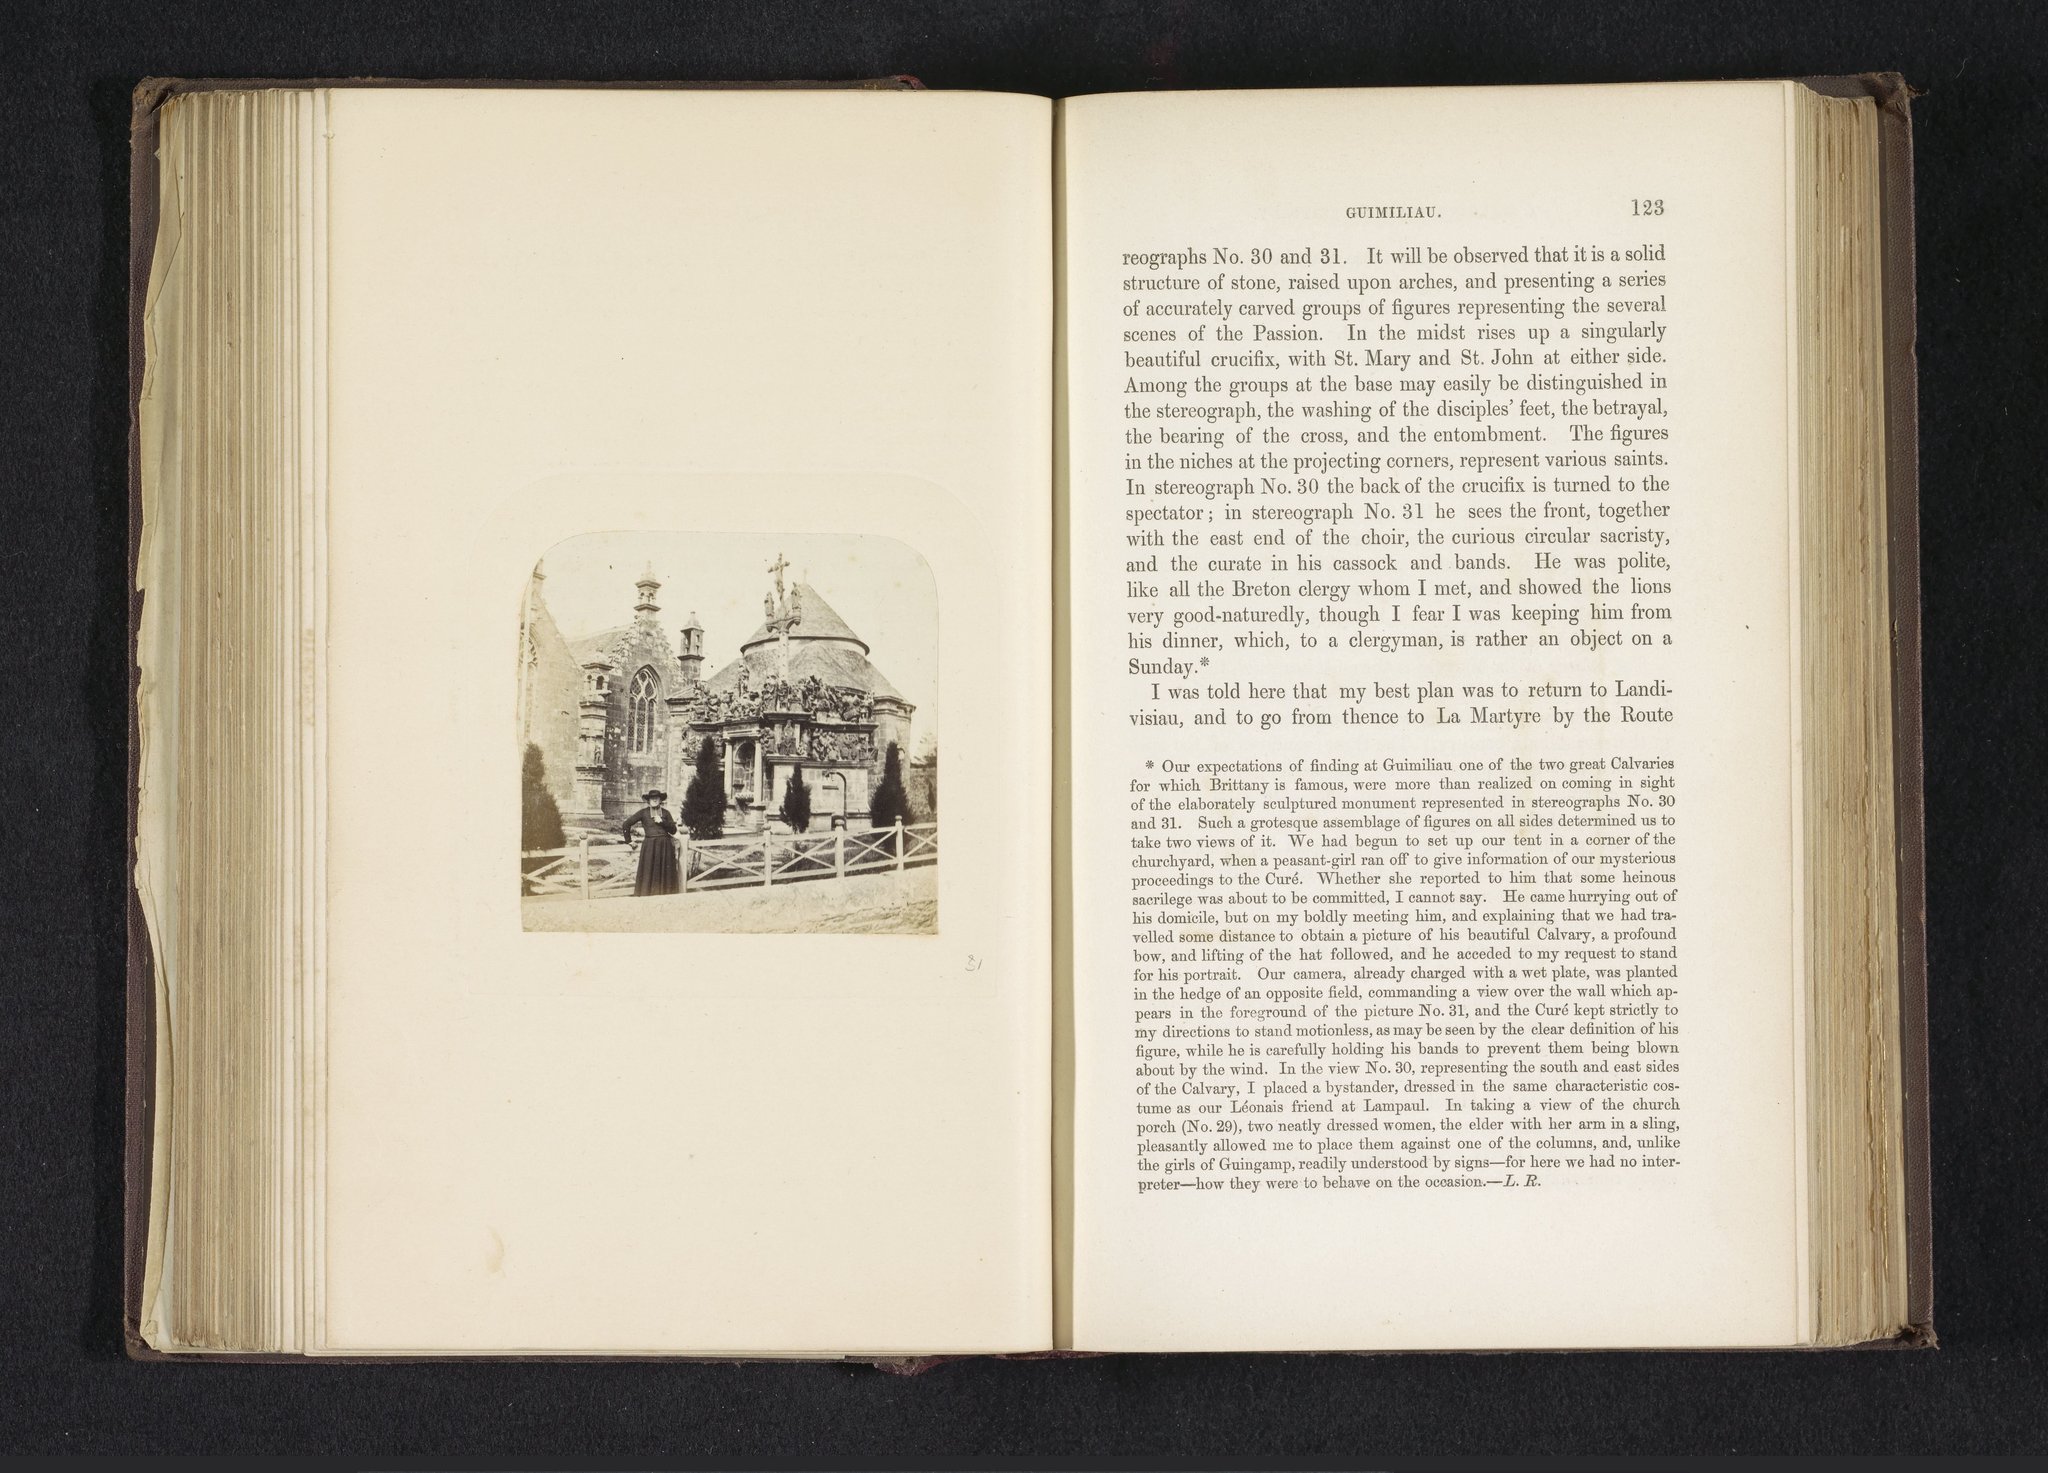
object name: page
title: Geestelijke bij het kerkhof en de sacristie van Guimiliau, gezien vanuit het zuidwesten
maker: taylor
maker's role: fotograaf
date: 1850-1859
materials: photographic support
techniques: albumen print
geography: guimiliau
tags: parts of church interior: sacristy, priest (roman catholic), churchyard, cemetery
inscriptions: number: ‘31’